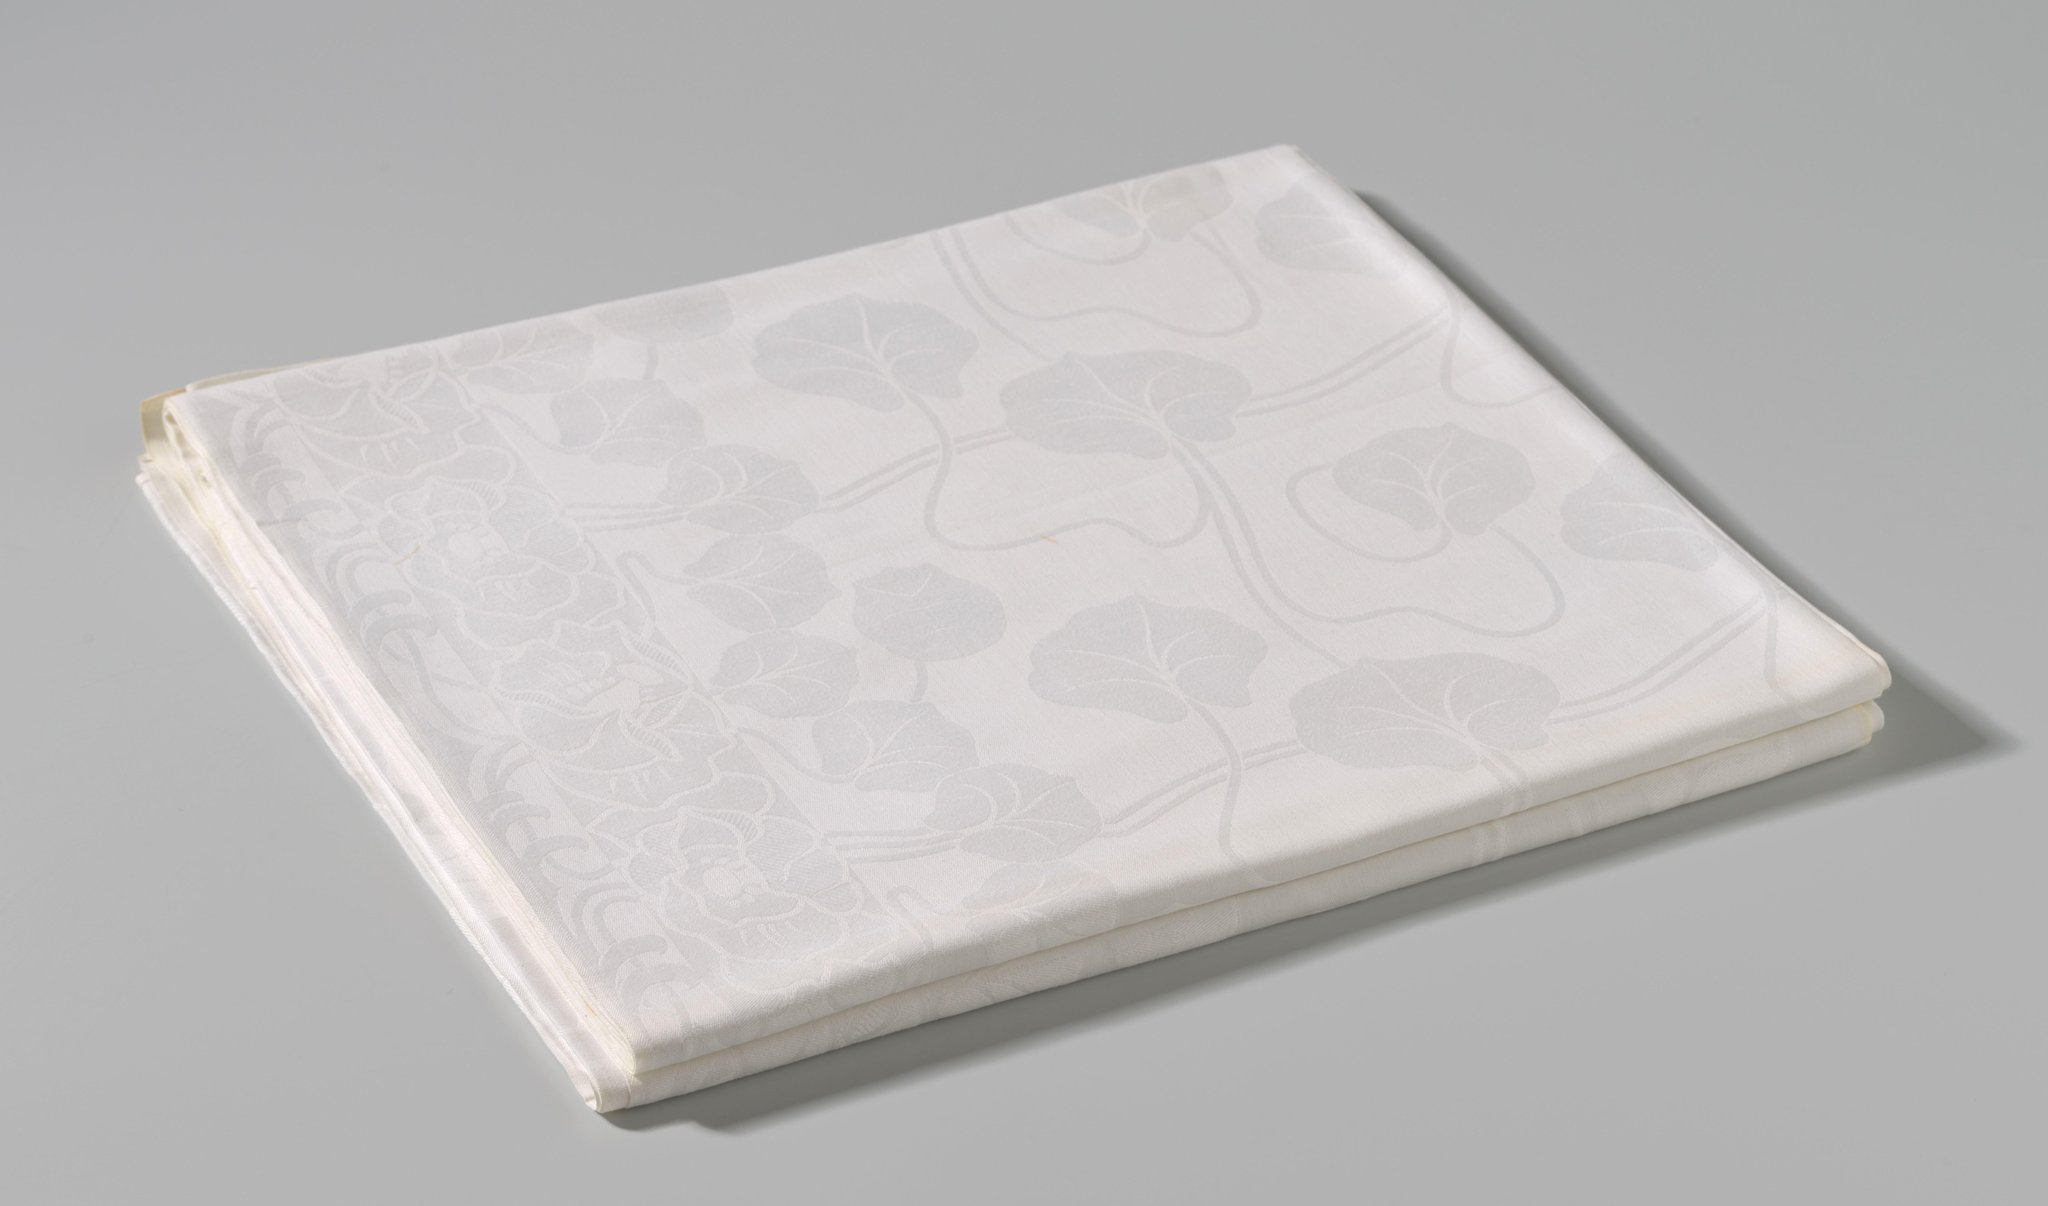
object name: tablecloth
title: Tafellaken van linnendamast met bladeren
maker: Anonymous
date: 1890-1910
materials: linen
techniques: damask, weave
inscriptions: number: ‘2559’, mark: ‘KUP’, monogram: ‘KS’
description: Tafellaken van linnendamast met bladeren aan kronkelende stengels en een rand van gestileerde bloemen. Het laken is gemerkt: KUP en een aangenaaid nummer (2559 in rood op wit) en een monogram: KS. Bij het tafellaken horen zes servetten (BK-1970-129-B t/m BK-1970-129-G).